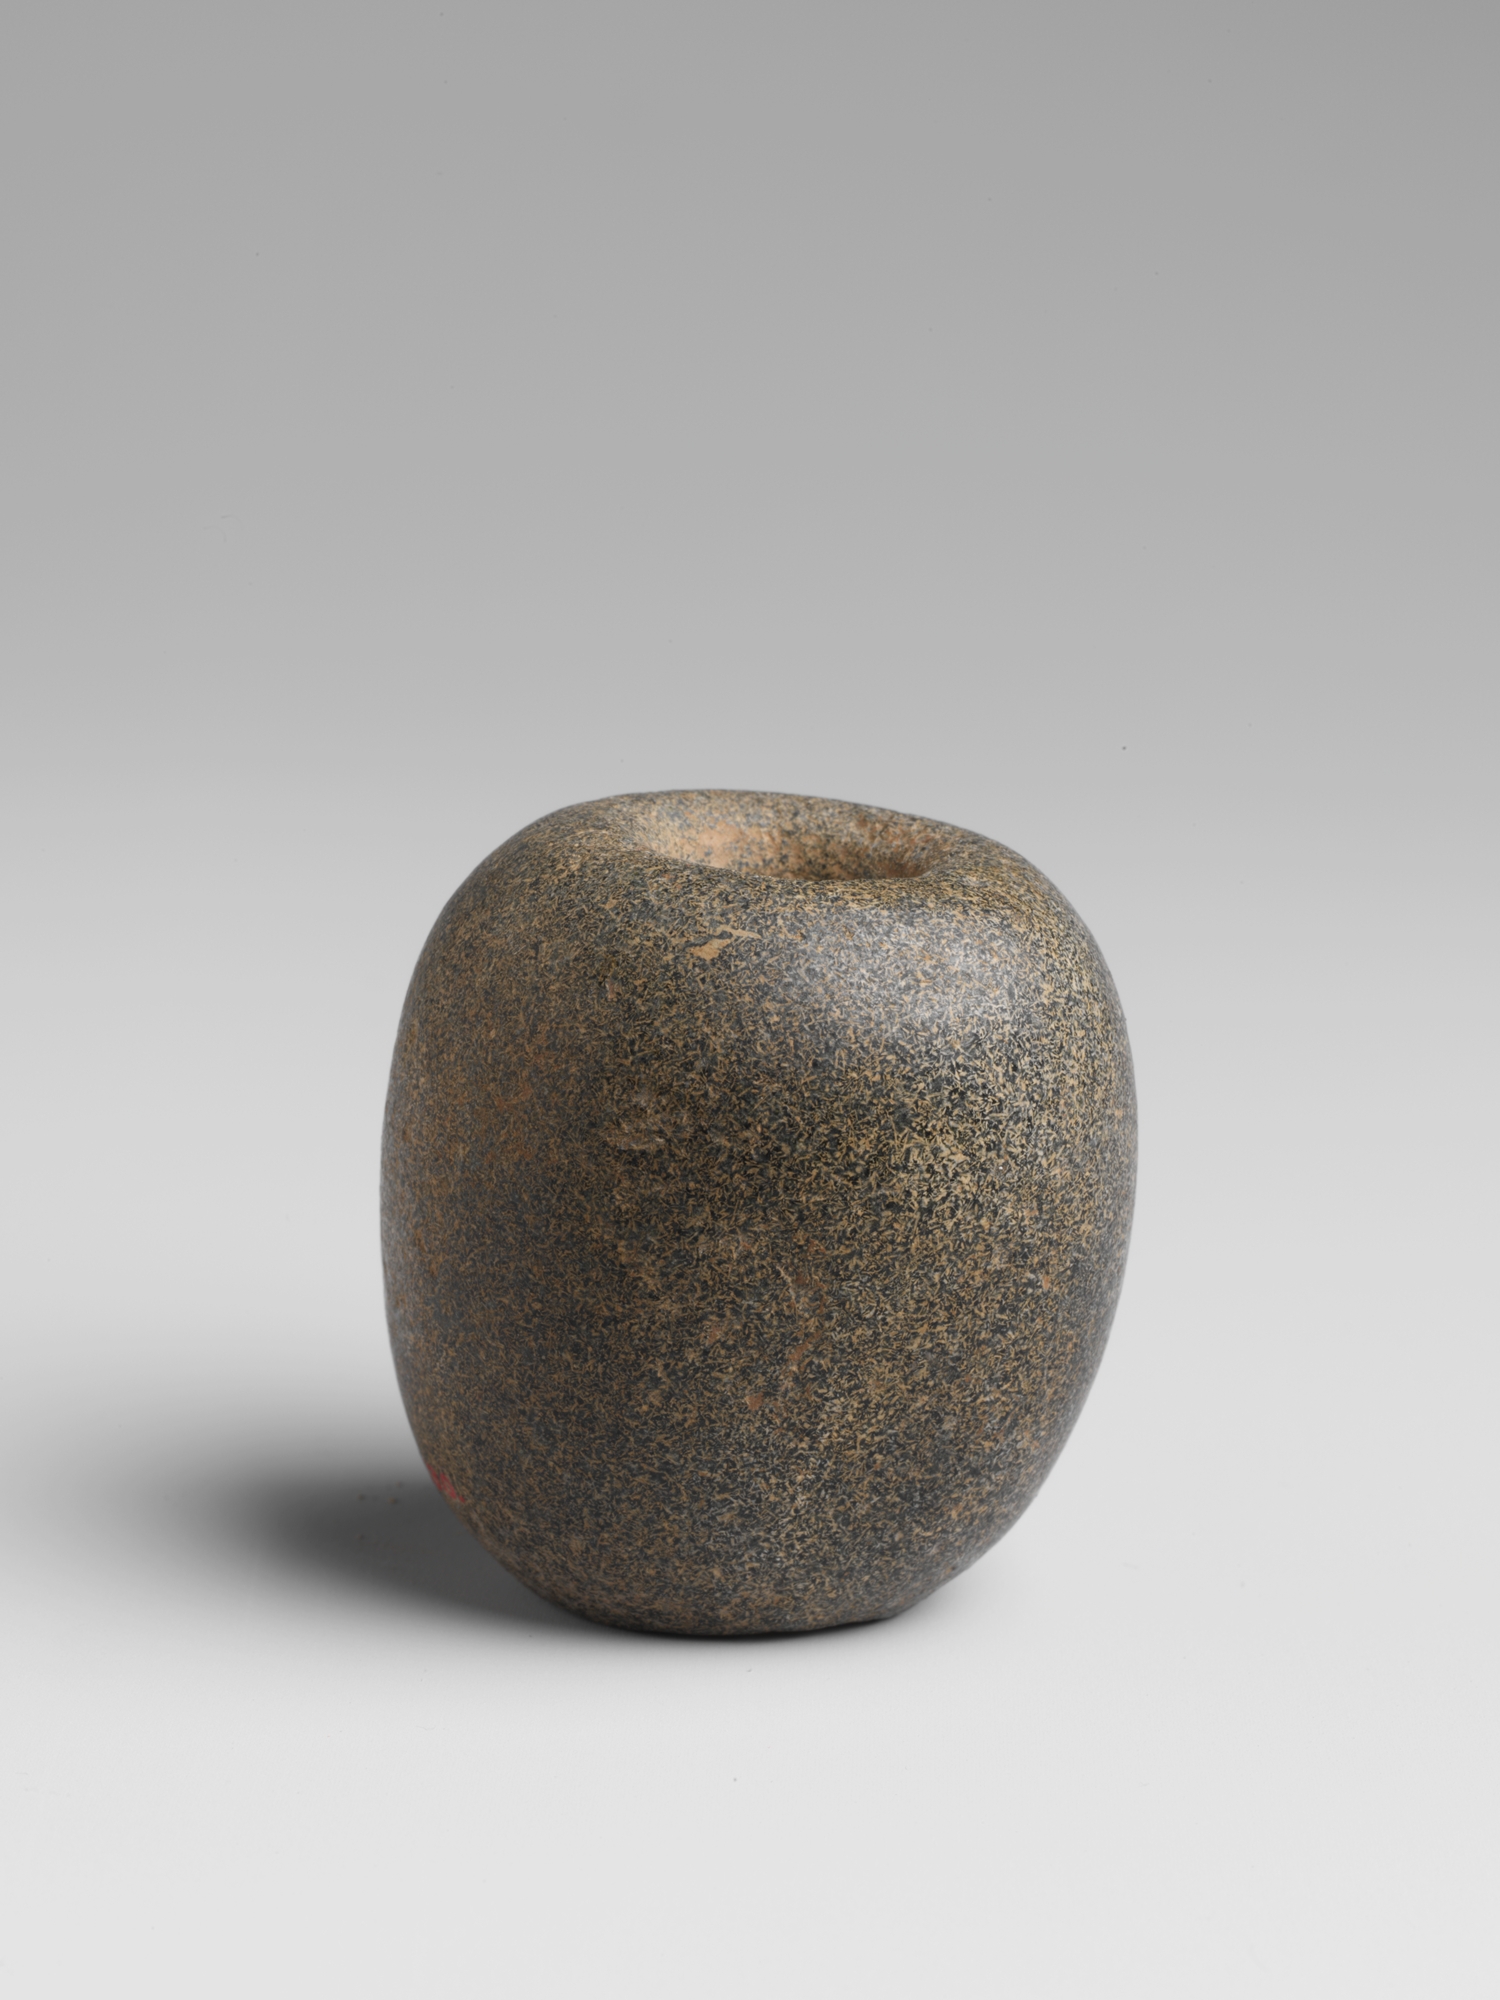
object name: mace head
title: Gabbro mace head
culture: cypriot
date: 2500-1900 BCE